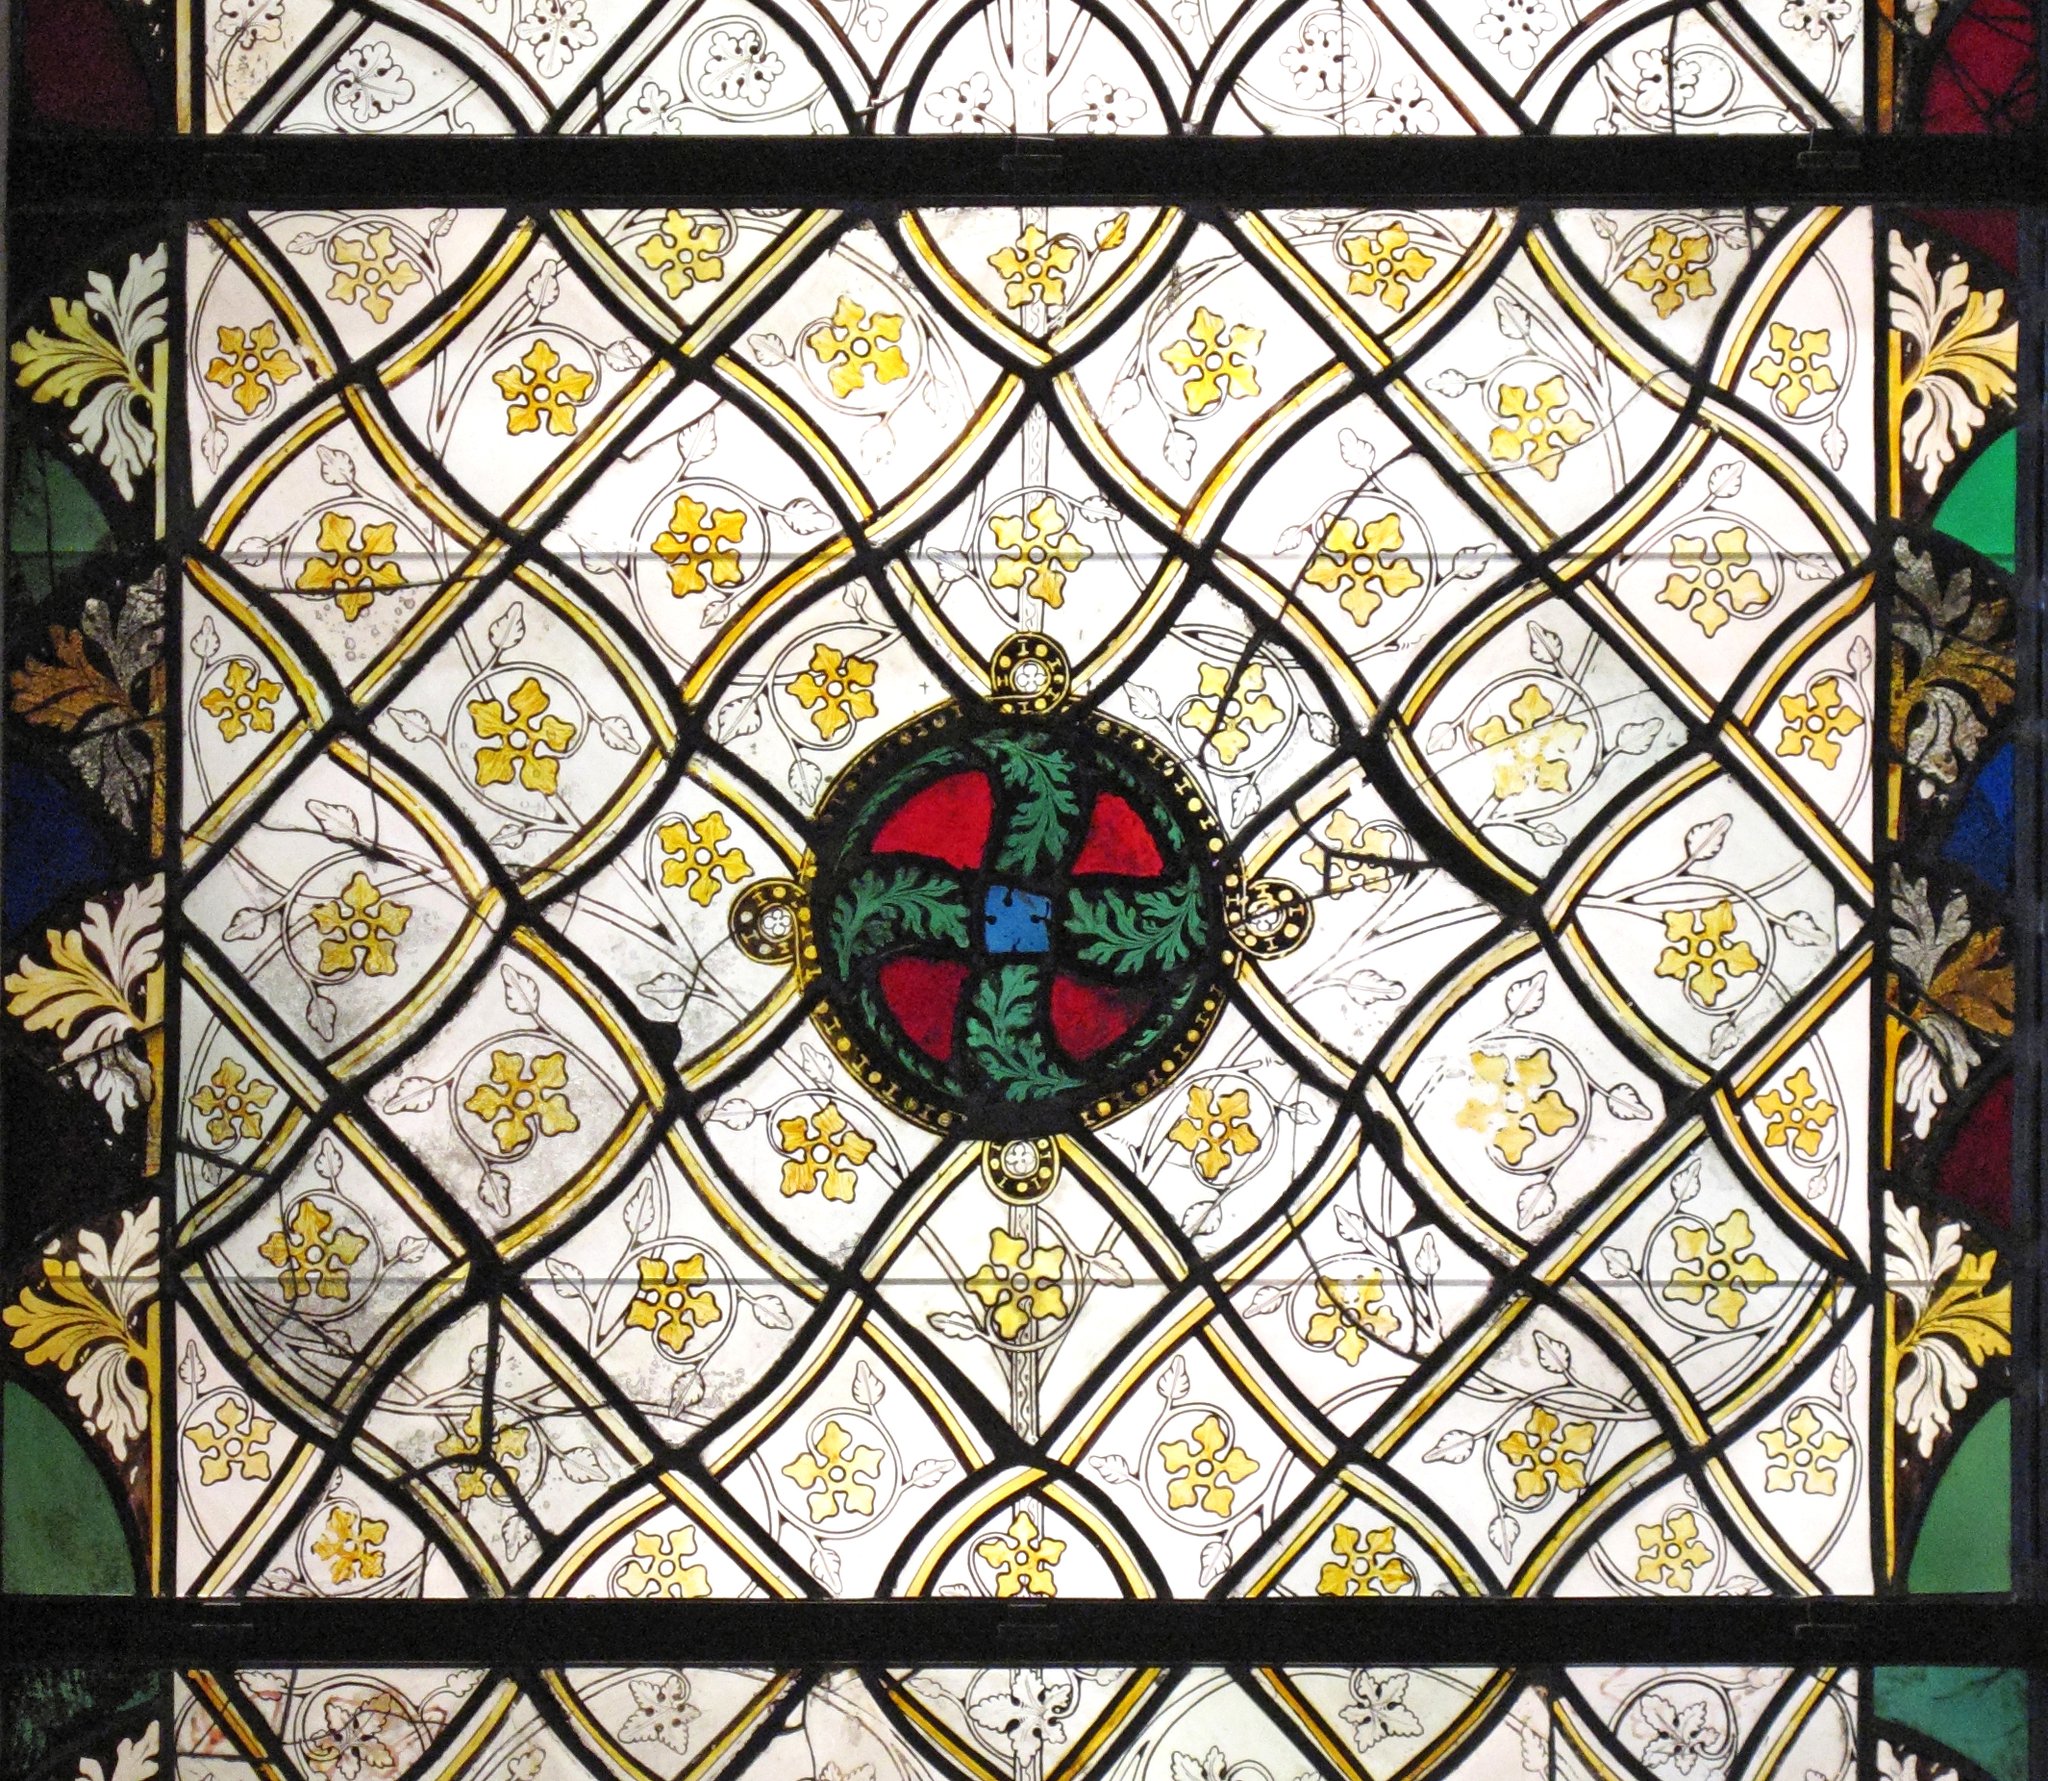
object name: panel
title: Grisaille Panels with Stylized Periwinkle Flowers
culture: french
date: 1320-1330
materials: glass, metal, paint, pigment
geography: france